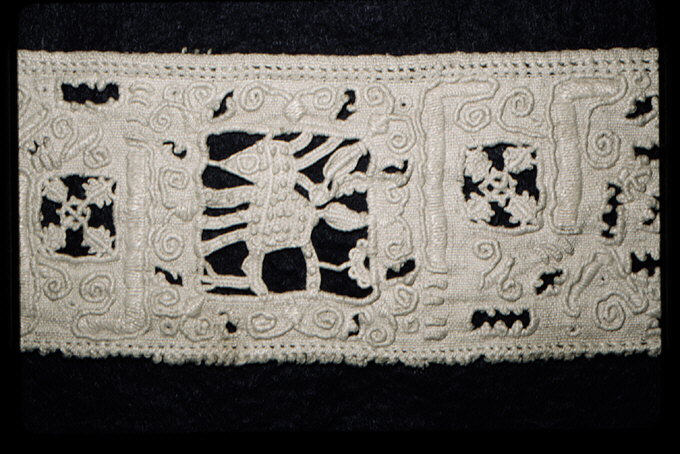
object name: strip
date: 1501-1600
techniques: embroidery